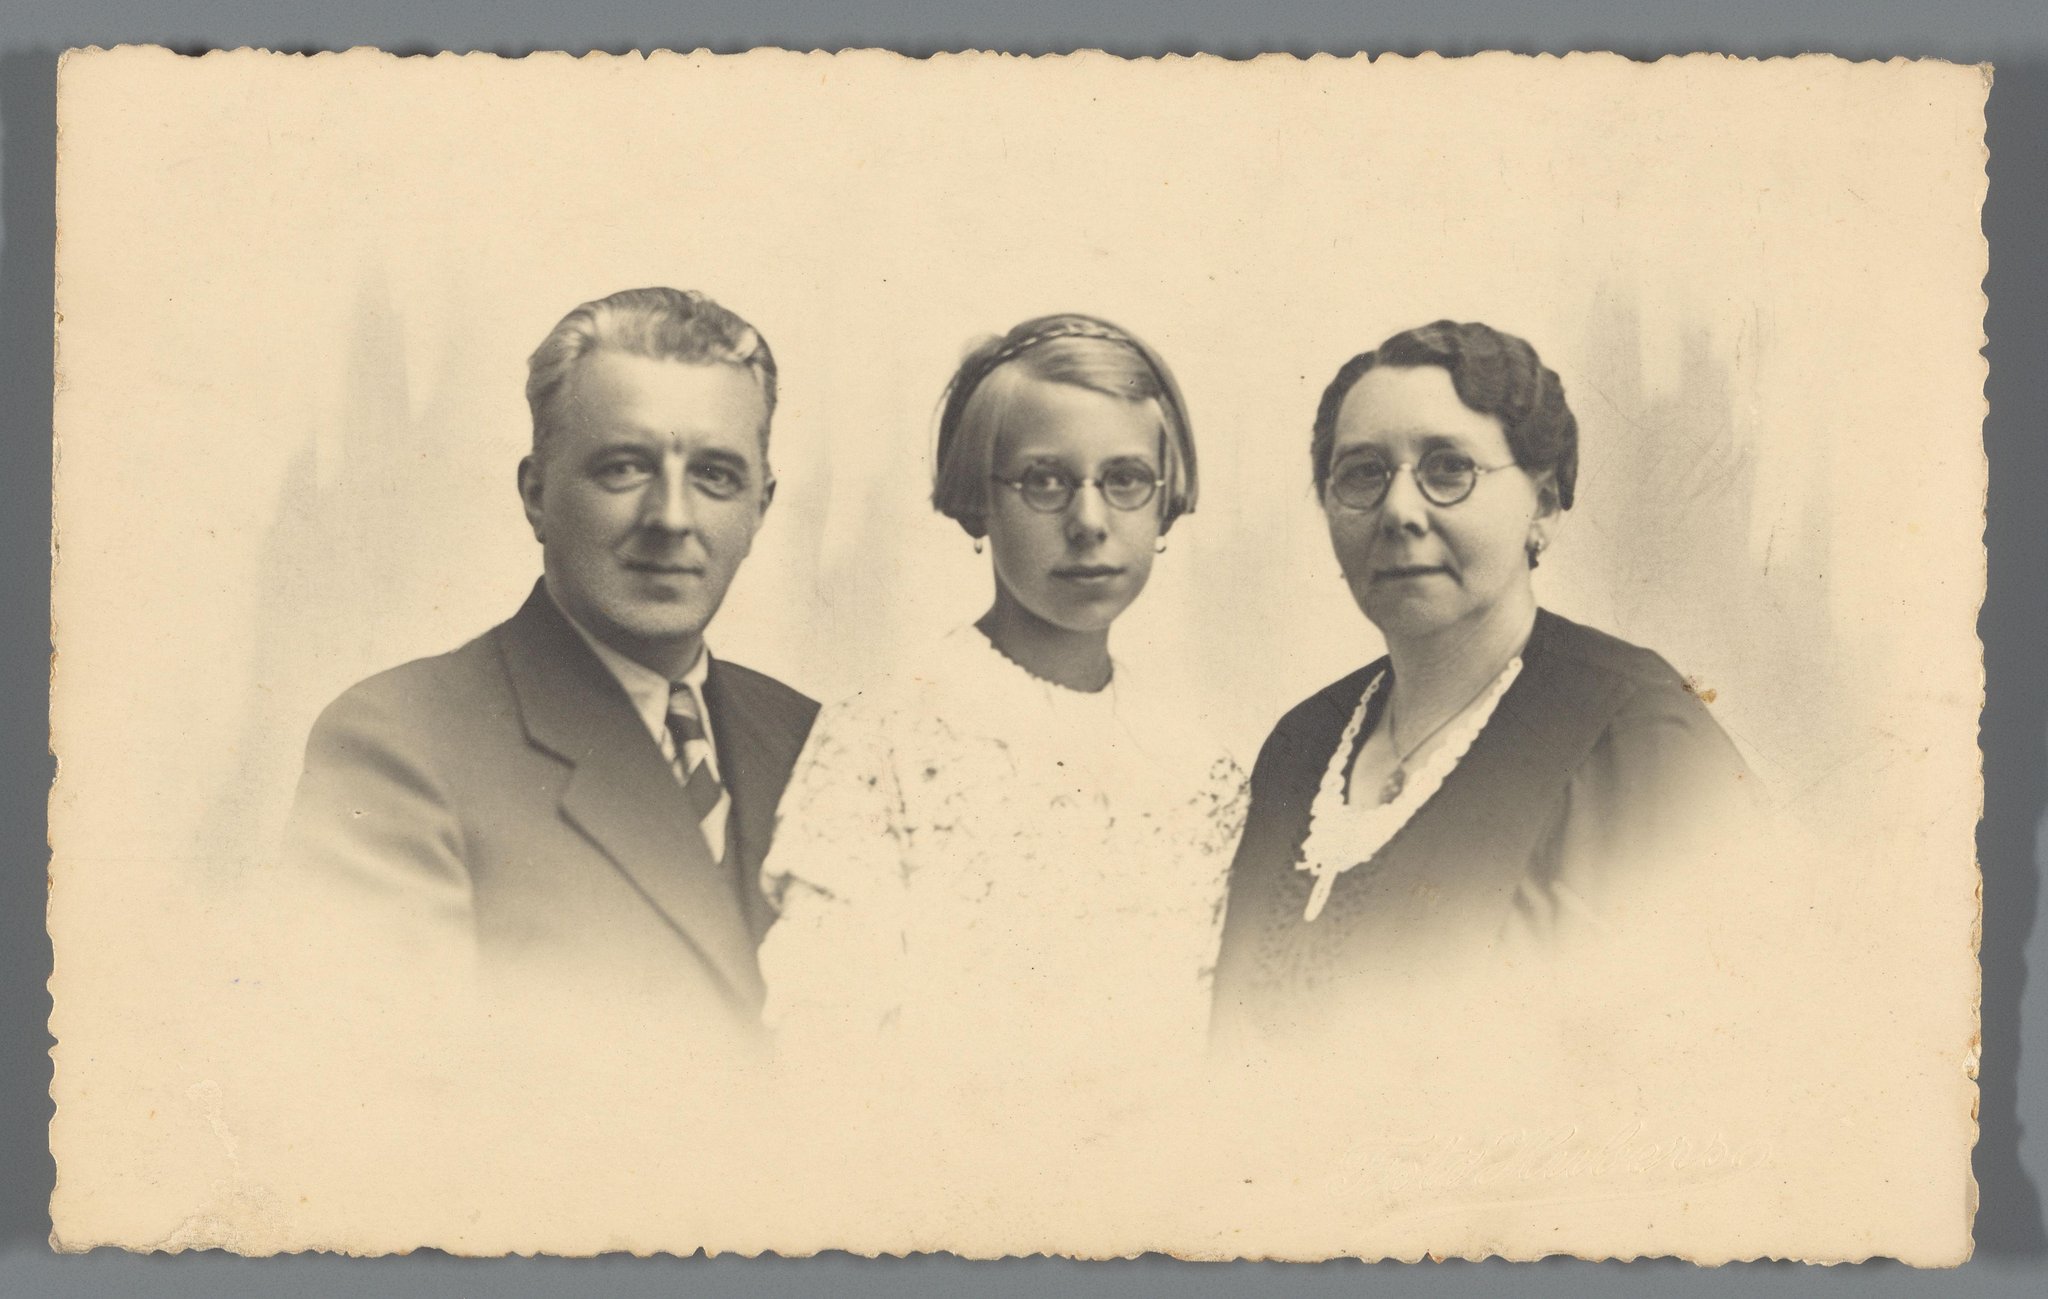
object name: photograph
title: Familieportret van drie onbekende mensen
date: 1920-1940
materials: paper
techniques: gelatin silver print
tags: family, relationship, descent, anonymous historical persons portrayed in a group, in a group-portrait